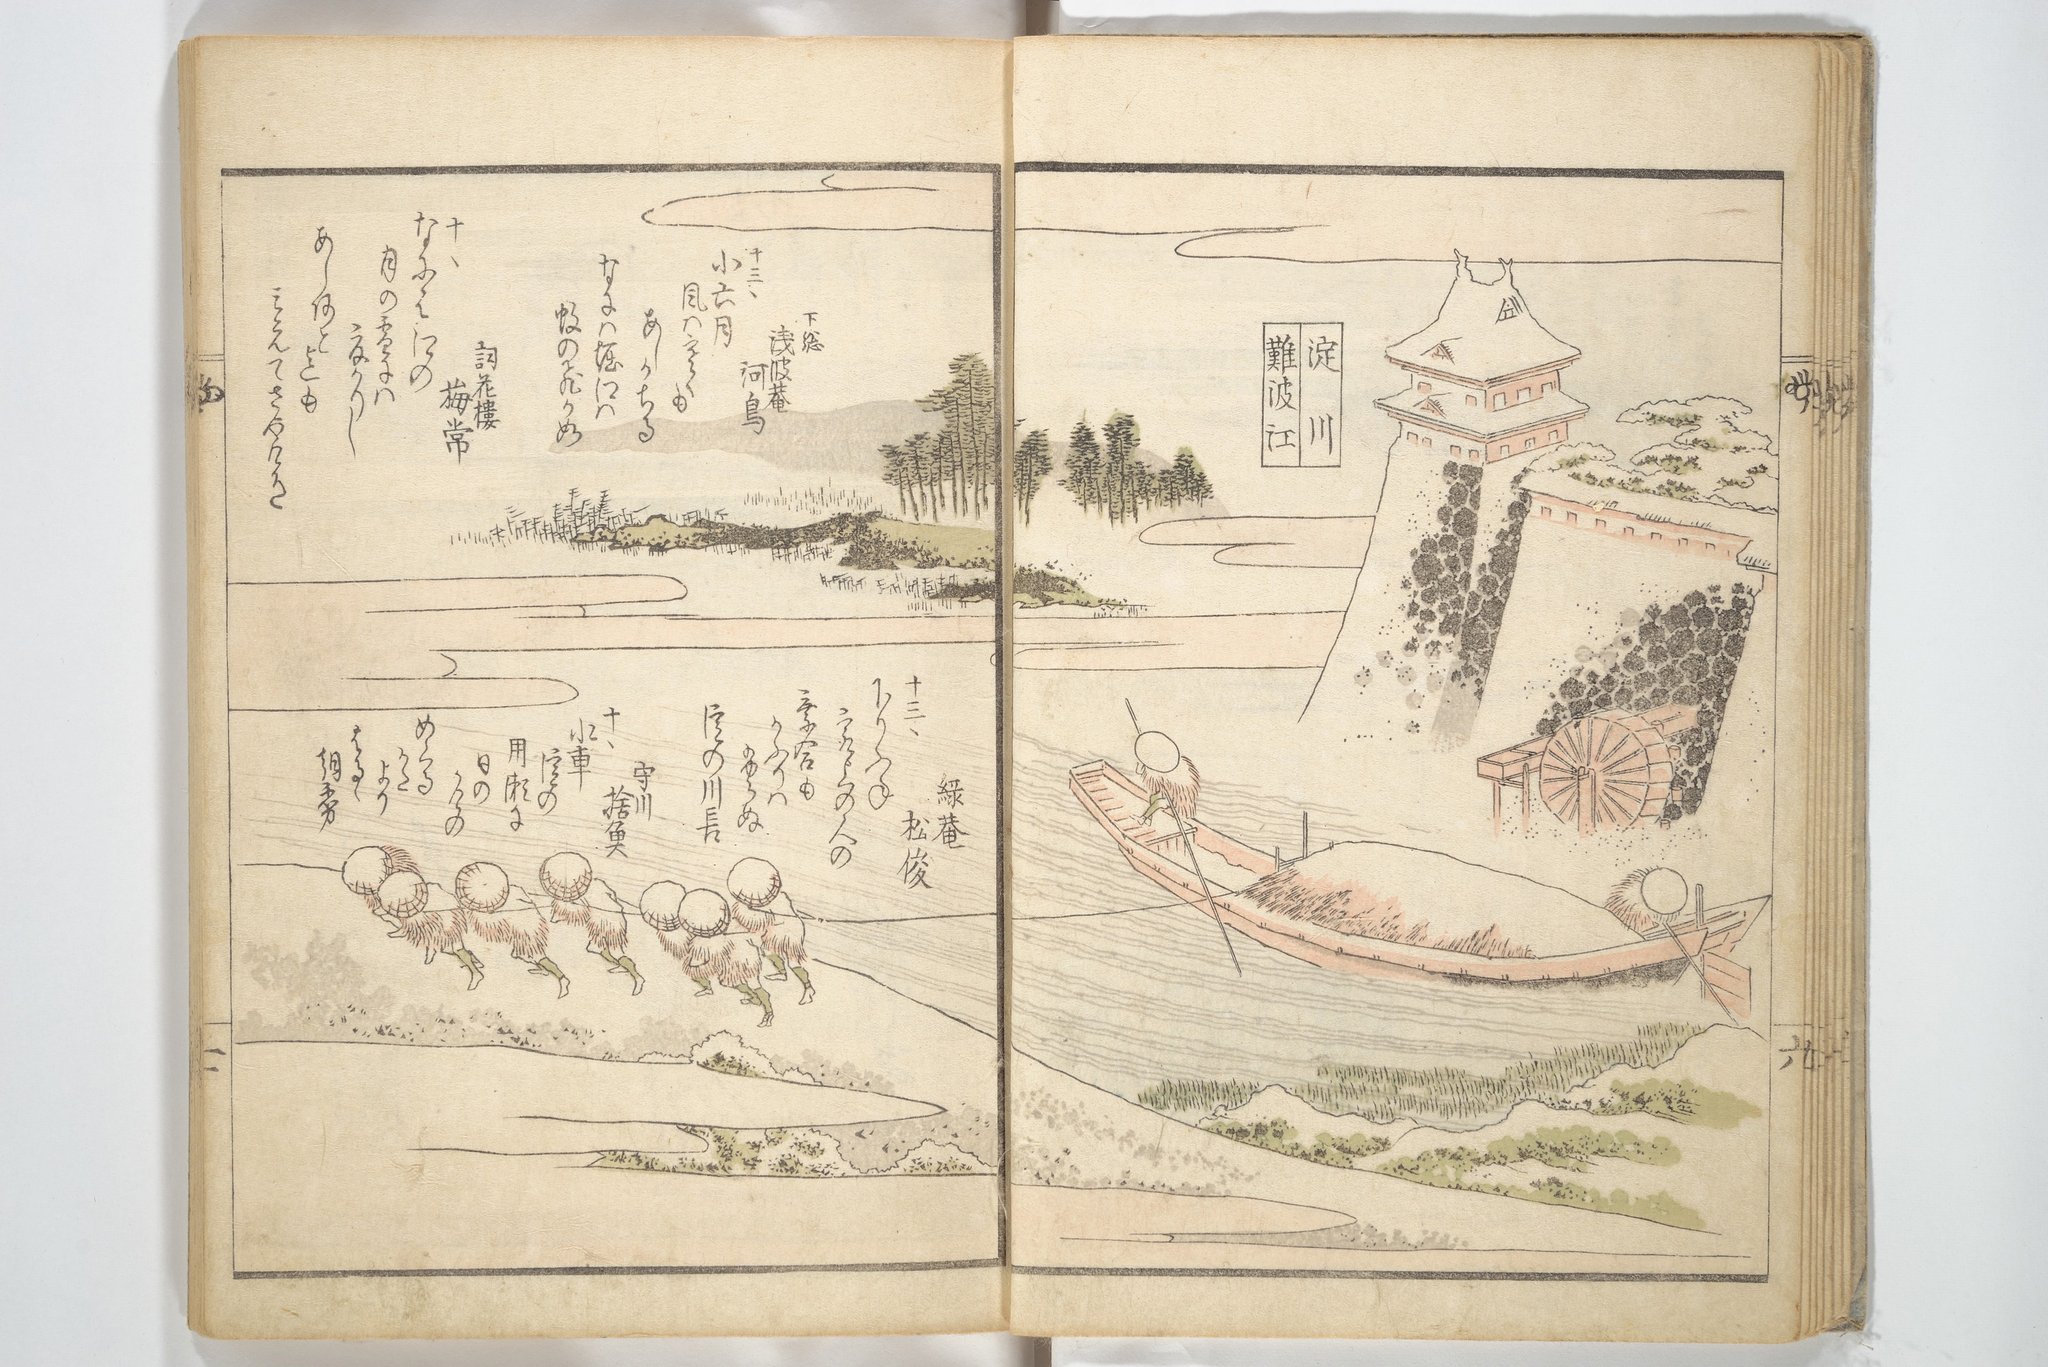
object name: illustrated book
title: Views of Famous Places in Japan Paired with Kyōka Poems (Kyōka fusō meisho zue) 狂歌扶桑名所図会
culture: japanese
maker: totoya hokkei 魚屋北渓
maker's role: artist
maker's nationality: japanese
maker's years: 1780-1850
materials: ink, paper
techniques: woodblock print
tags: human figures,poetry,buildings,boats